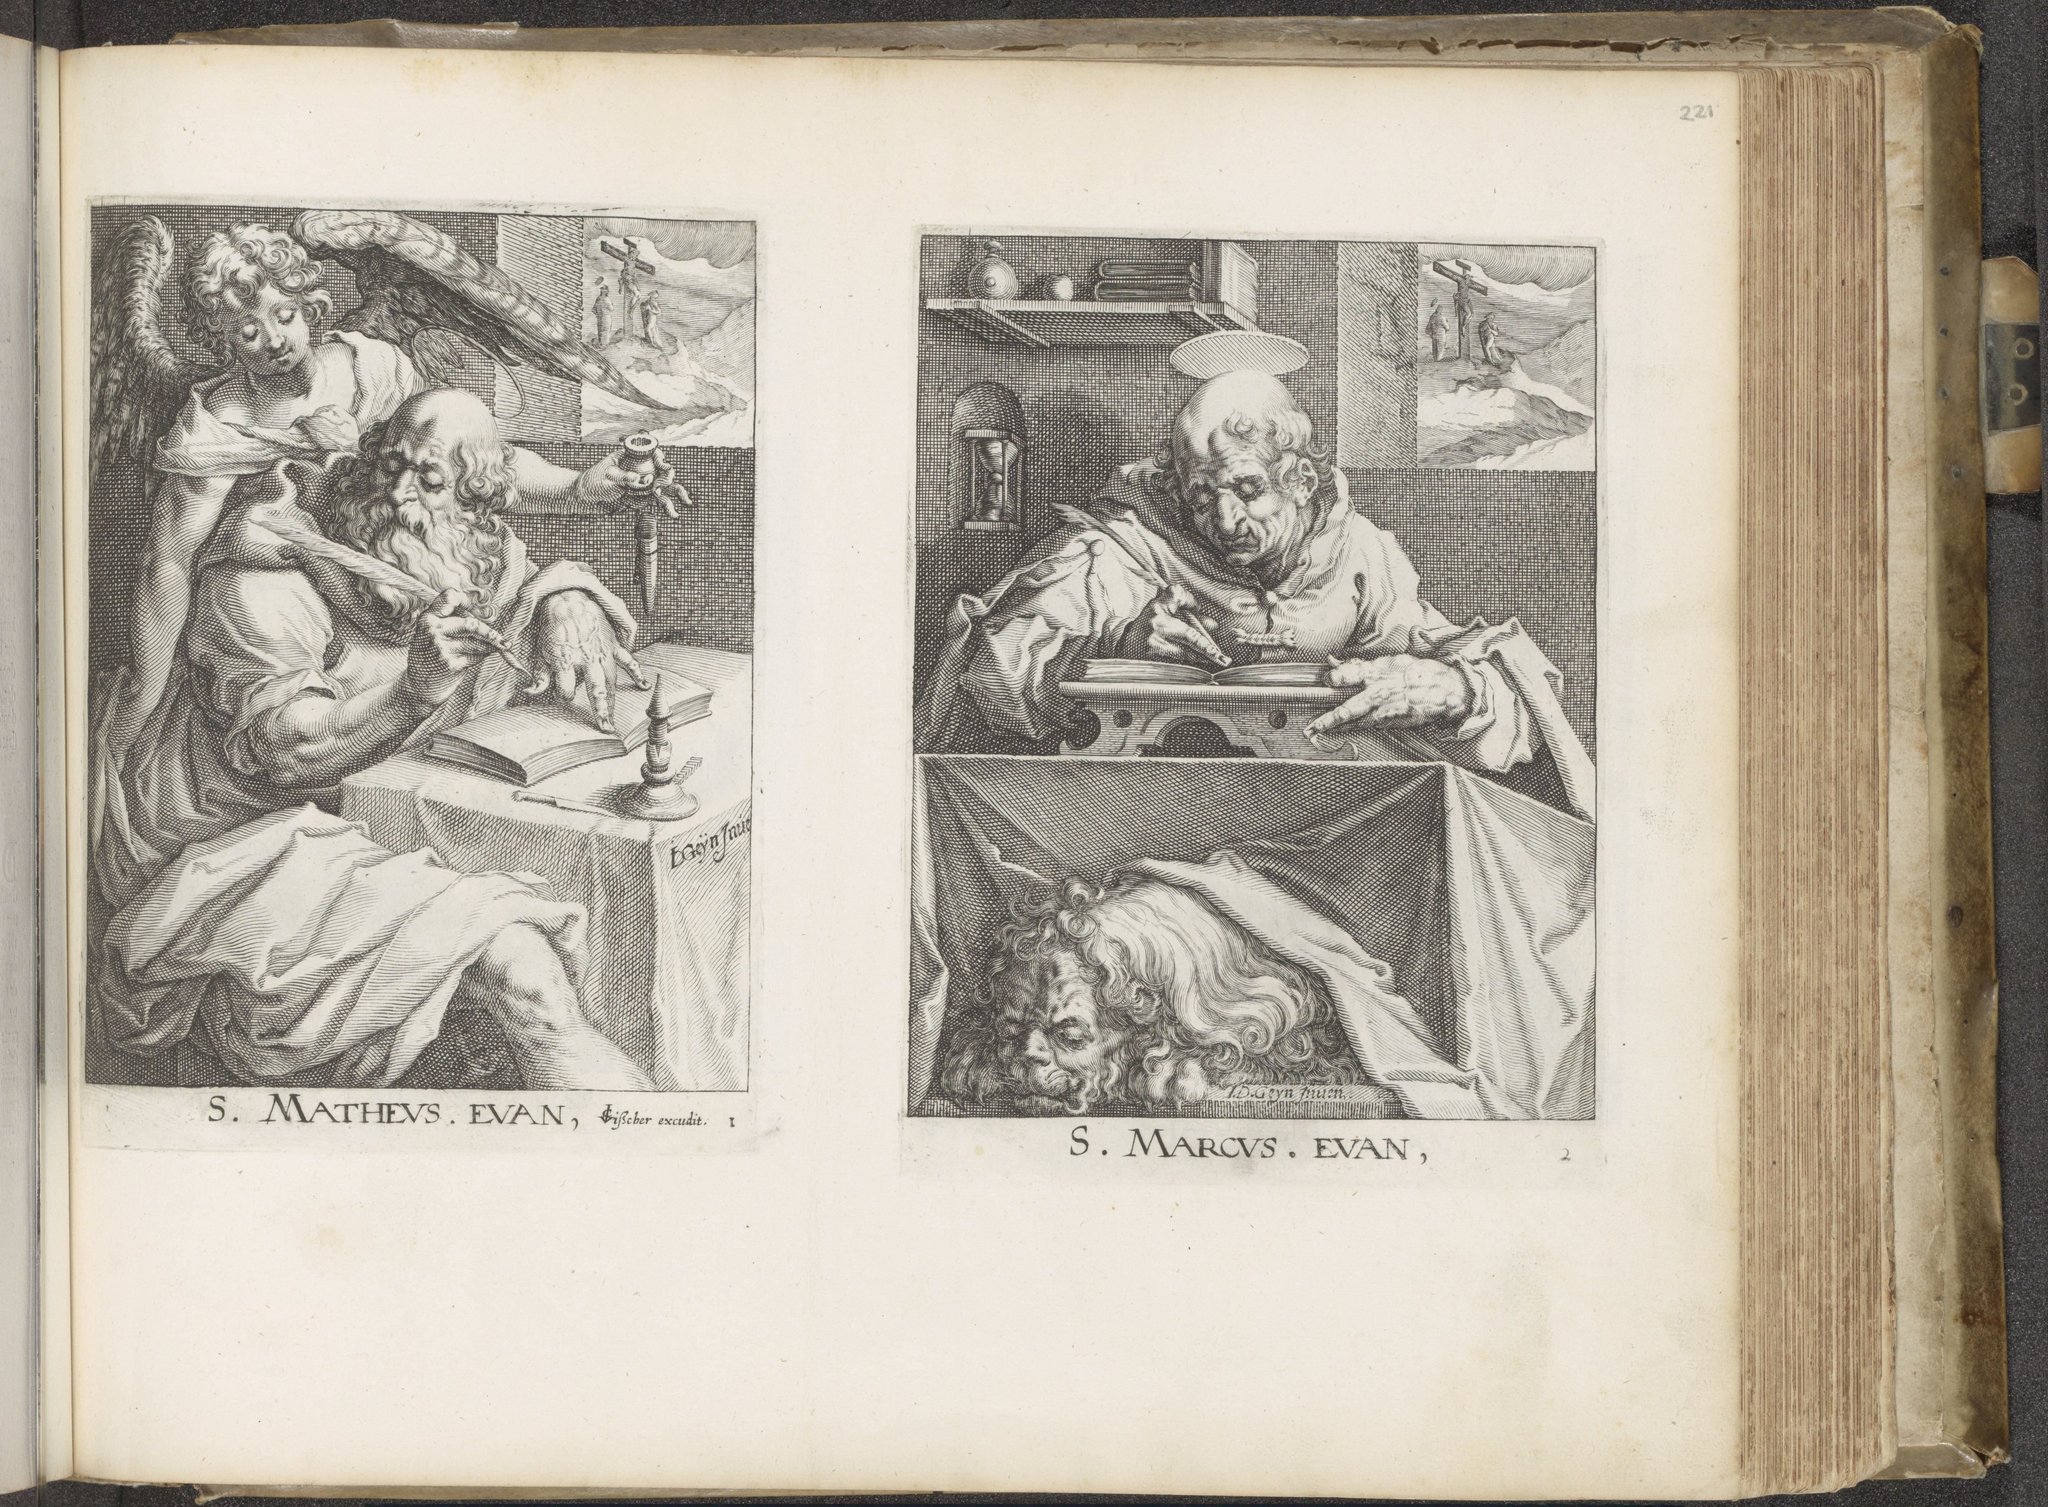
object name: print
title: Vier evangelisten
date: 1653-1654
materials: paper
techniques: engraving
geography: amsterdam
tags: crucified christ, with particular persons under the cross, the apostle and evangelist matthew (mattheus); possible attributes: angel, axe, book, halberd, pen and inkhorn, purse, scroll, square, sword, mark (marcus) the evangelist, and bishop of alexandria; possible attributes: book, (winged) lion, pen and inkhorn, scroll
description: Twee voorstellingen op een albumblad. Links de evangelist Matthëus, schrijvend in een boek. Een engel houdt hem vanachter zijn rug een inktpot voor. Rechts de evangelist Marcus met een leeuw onder zijn schrijftafel. Op beide voorstellingen een raam met in de verte de Kruisiging van Christus. Het blad maakt deel uit van een album.